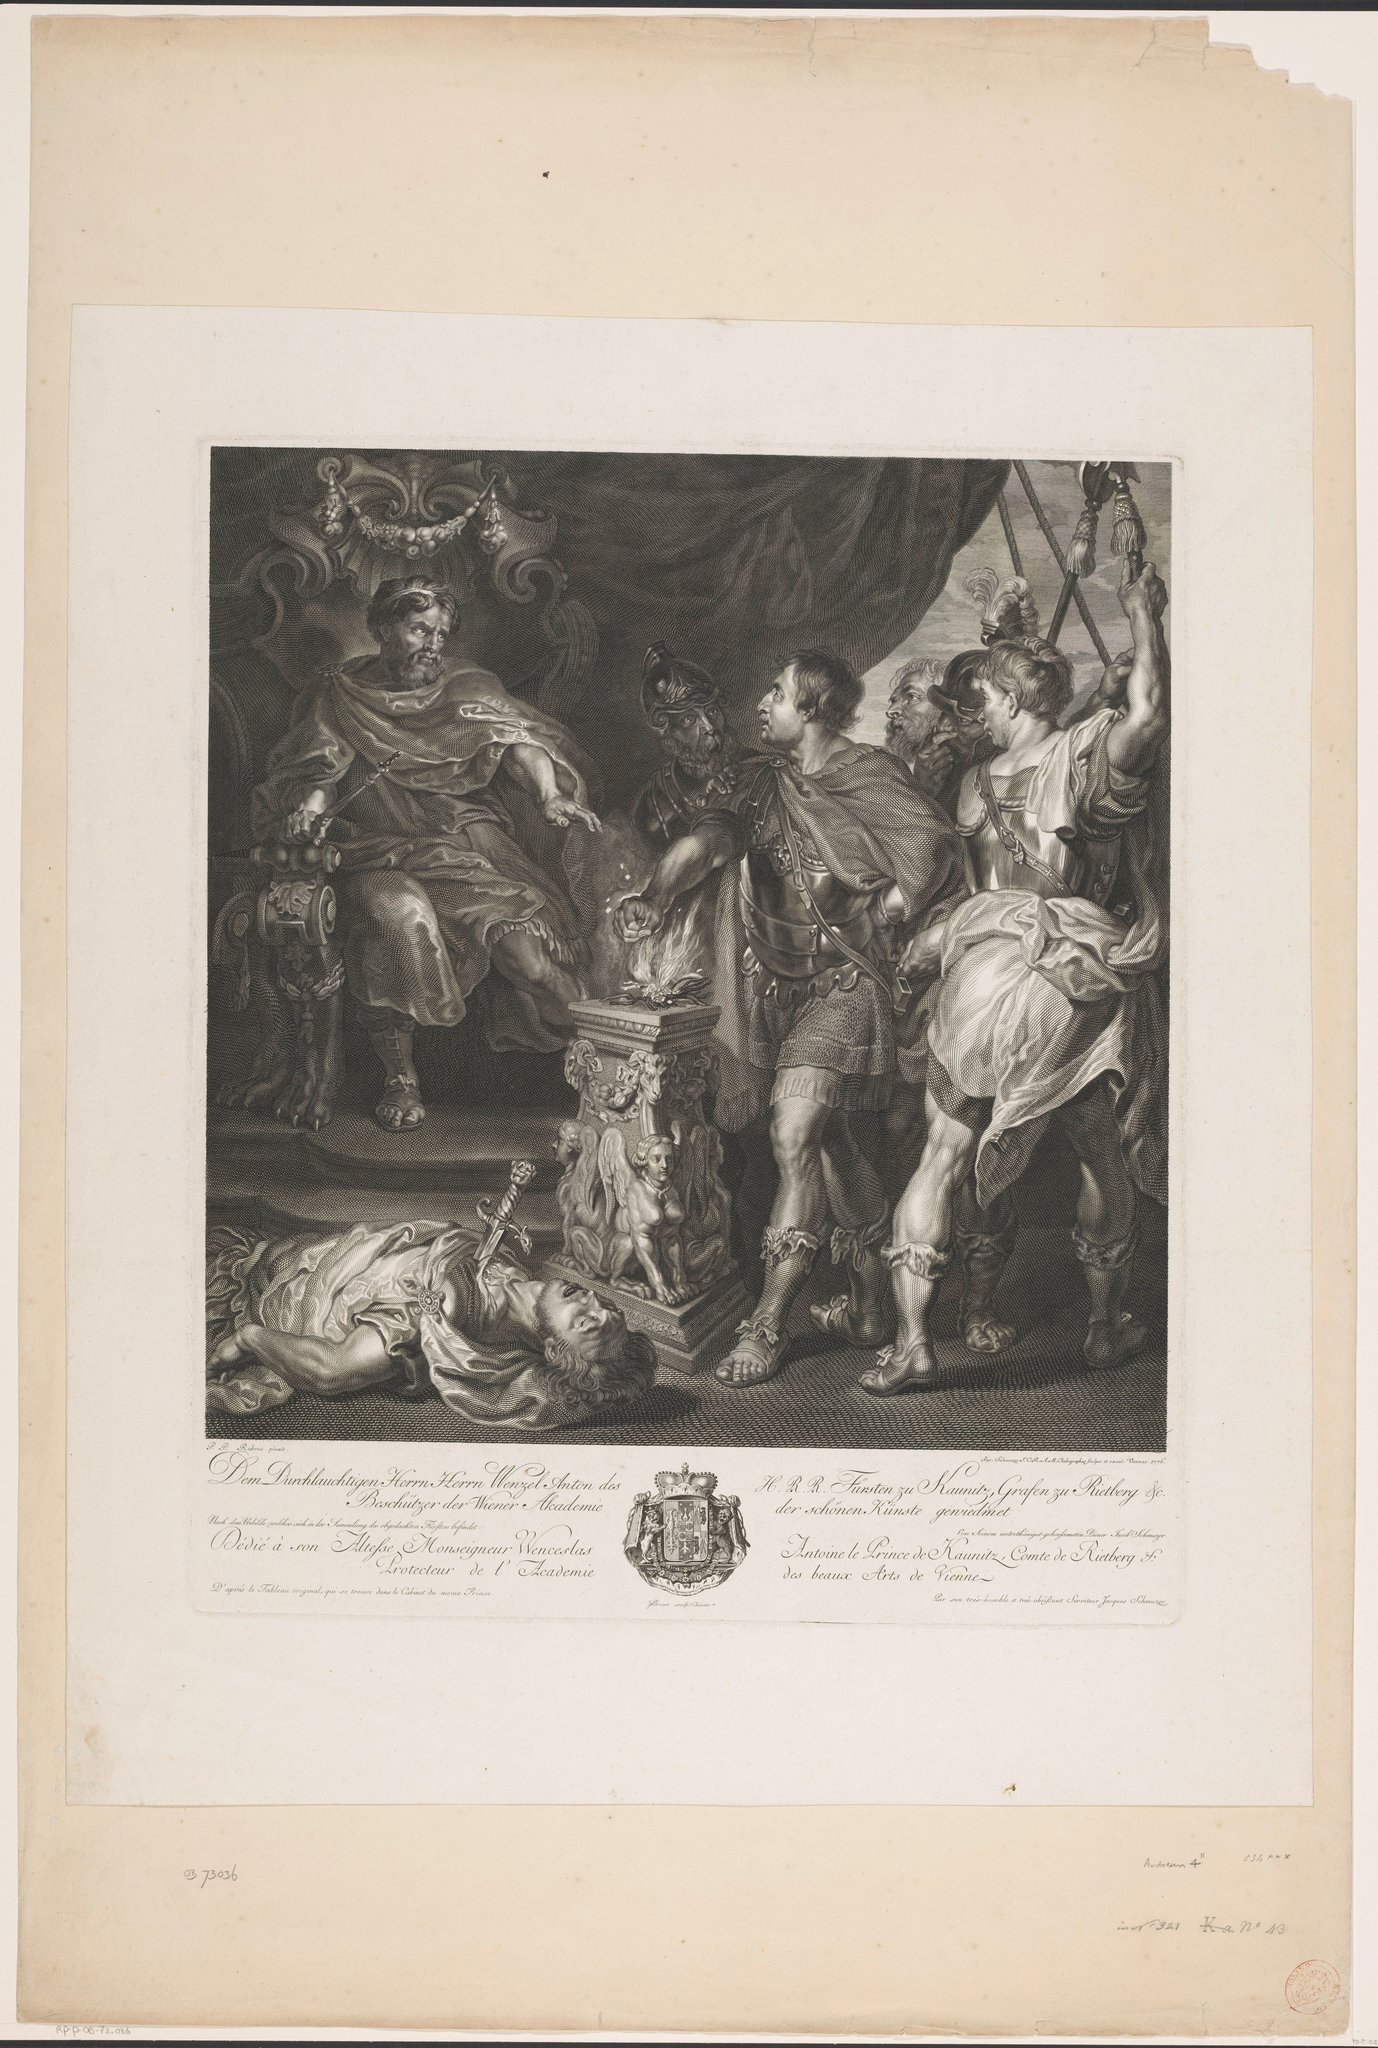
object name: print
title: Mucius Scaevola voor Lars Porsenna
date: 1776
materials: paper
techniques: engraving, etching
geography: germany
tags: gaius mucius scaevola before porsena: he thrusts his right hand into the flames (the body of the king's secretary who erroneously had been killed instead of porsena may be seen lying on the ground)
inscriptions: inscription: ‘Andresen 4 " 534 **x / invo 321 Ka No 43’, collector's mark: Lugt 240